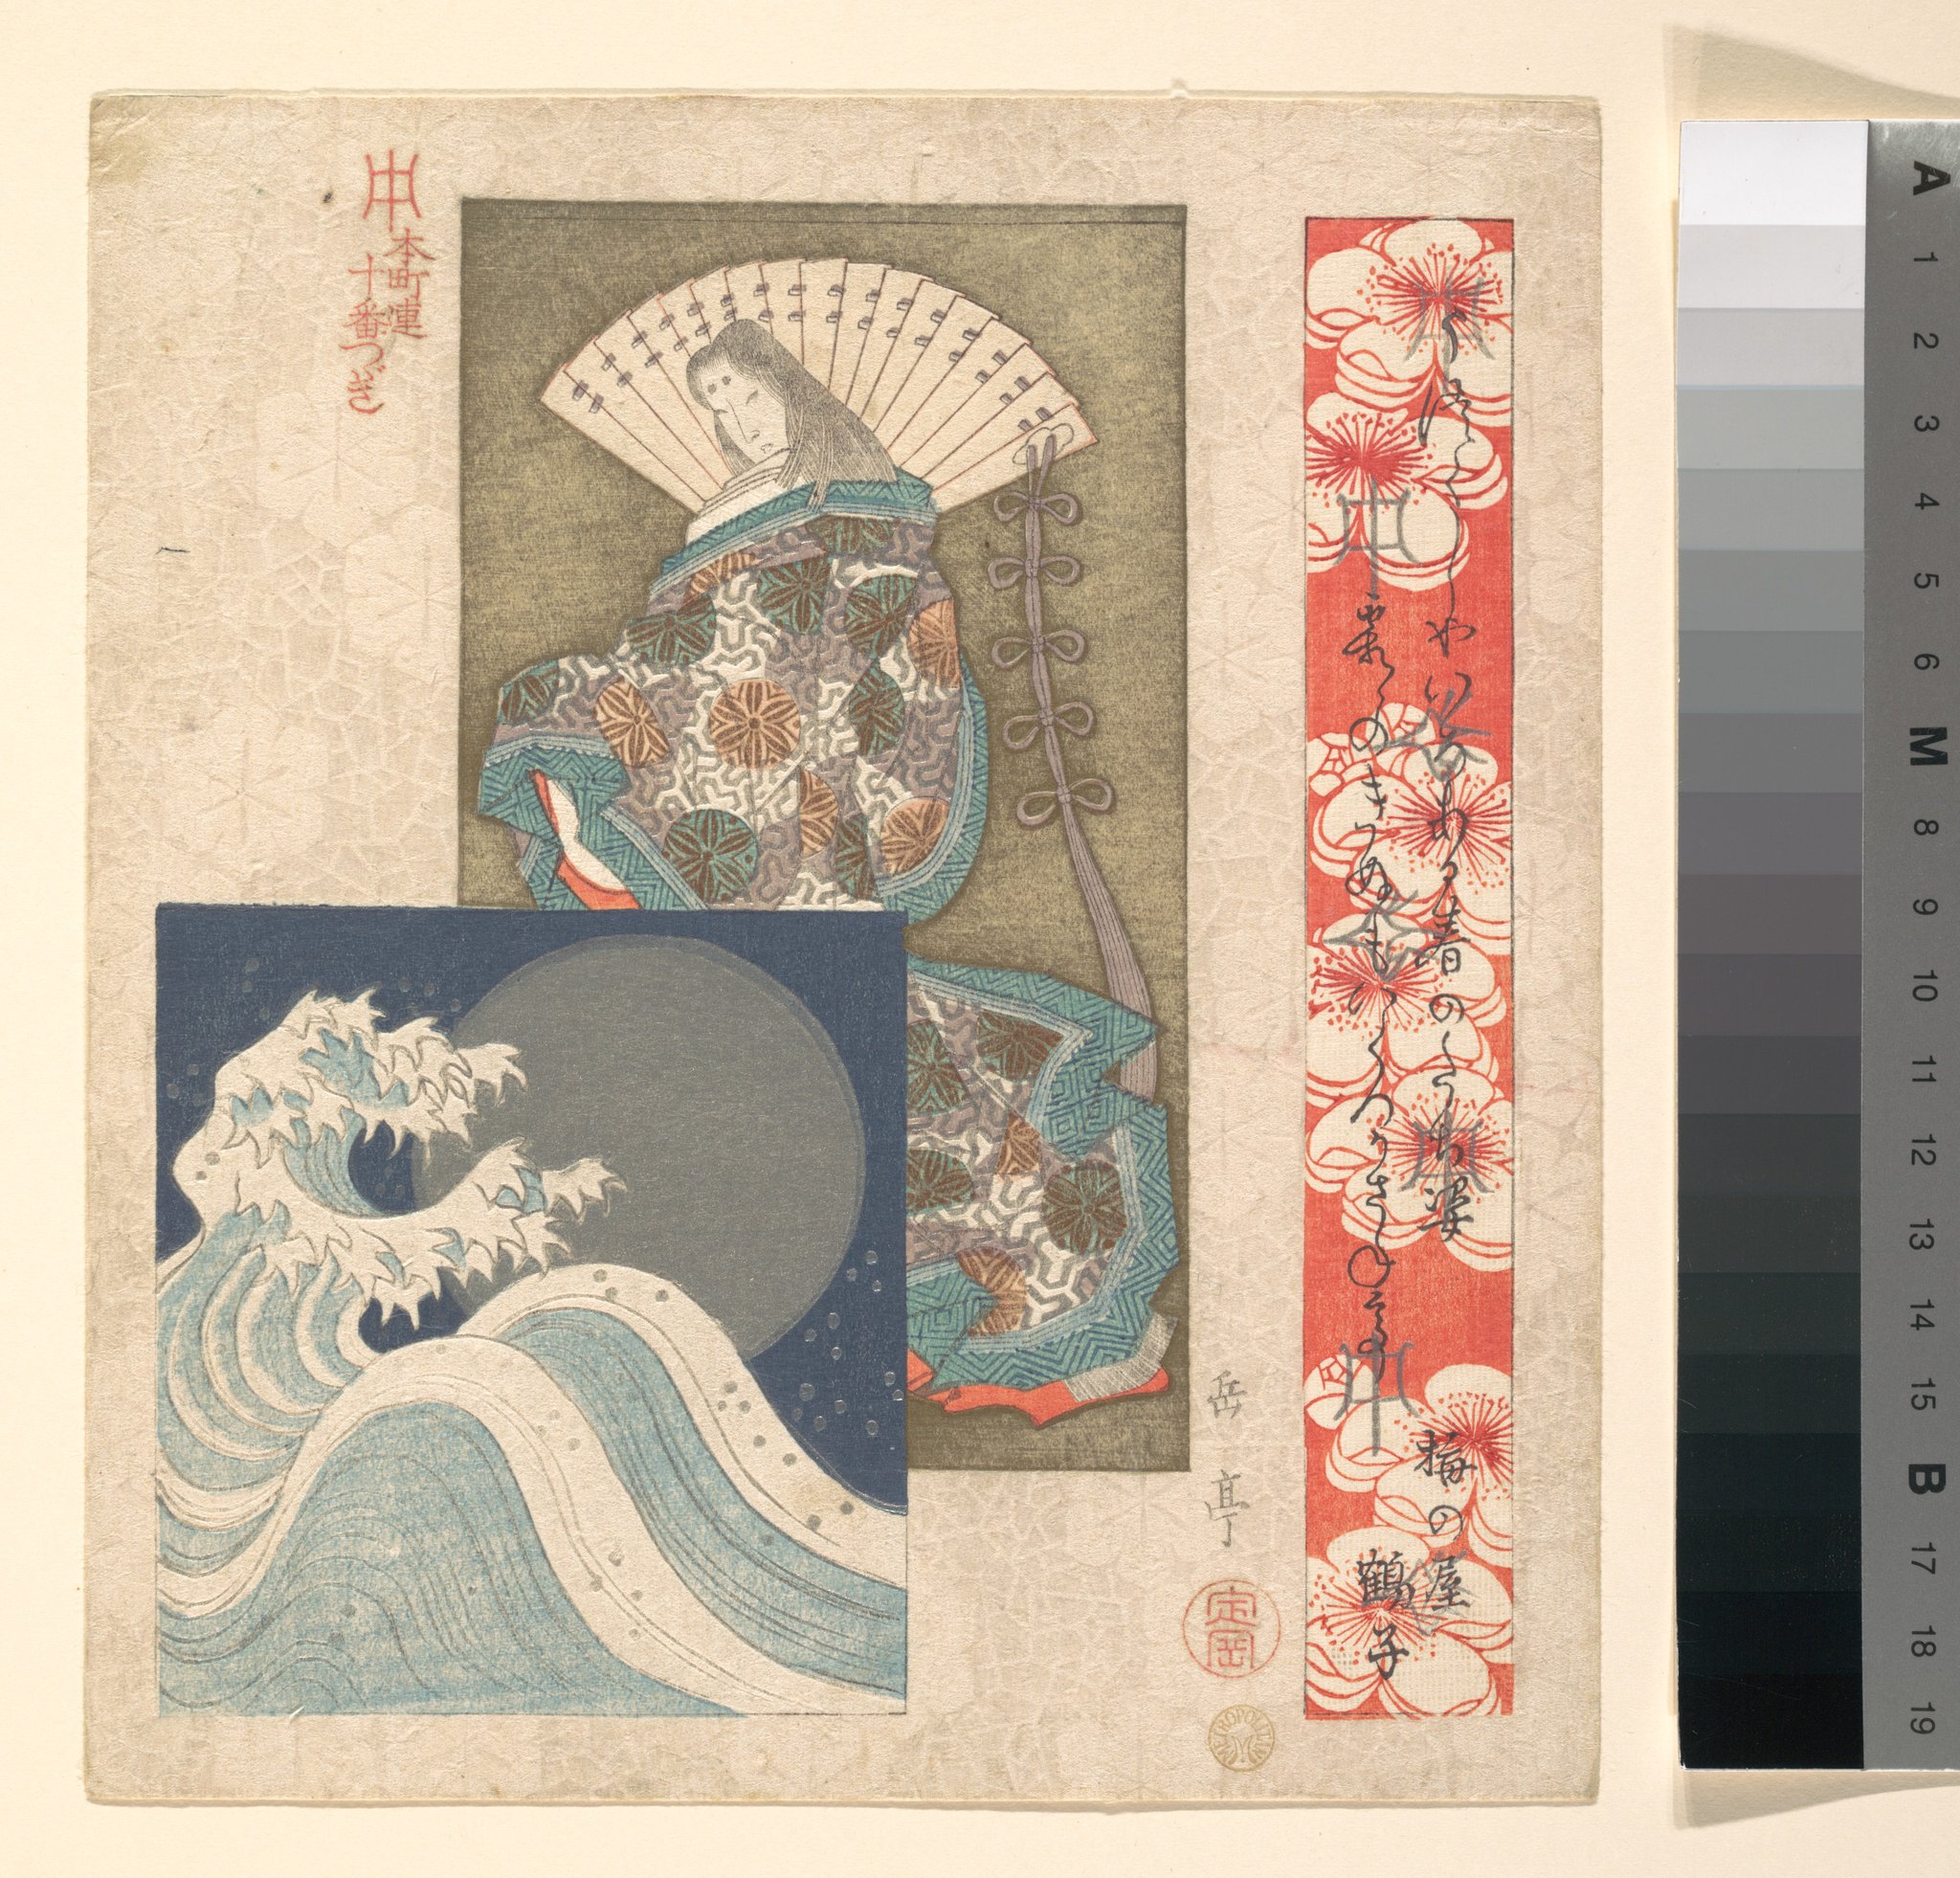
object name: print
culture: japanese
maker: yashima gakutei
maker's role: artist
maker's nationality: japanese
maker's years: 1786-1868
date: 1830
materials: ink, paper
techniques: surimono, woodblock print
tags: women,flowers,waves